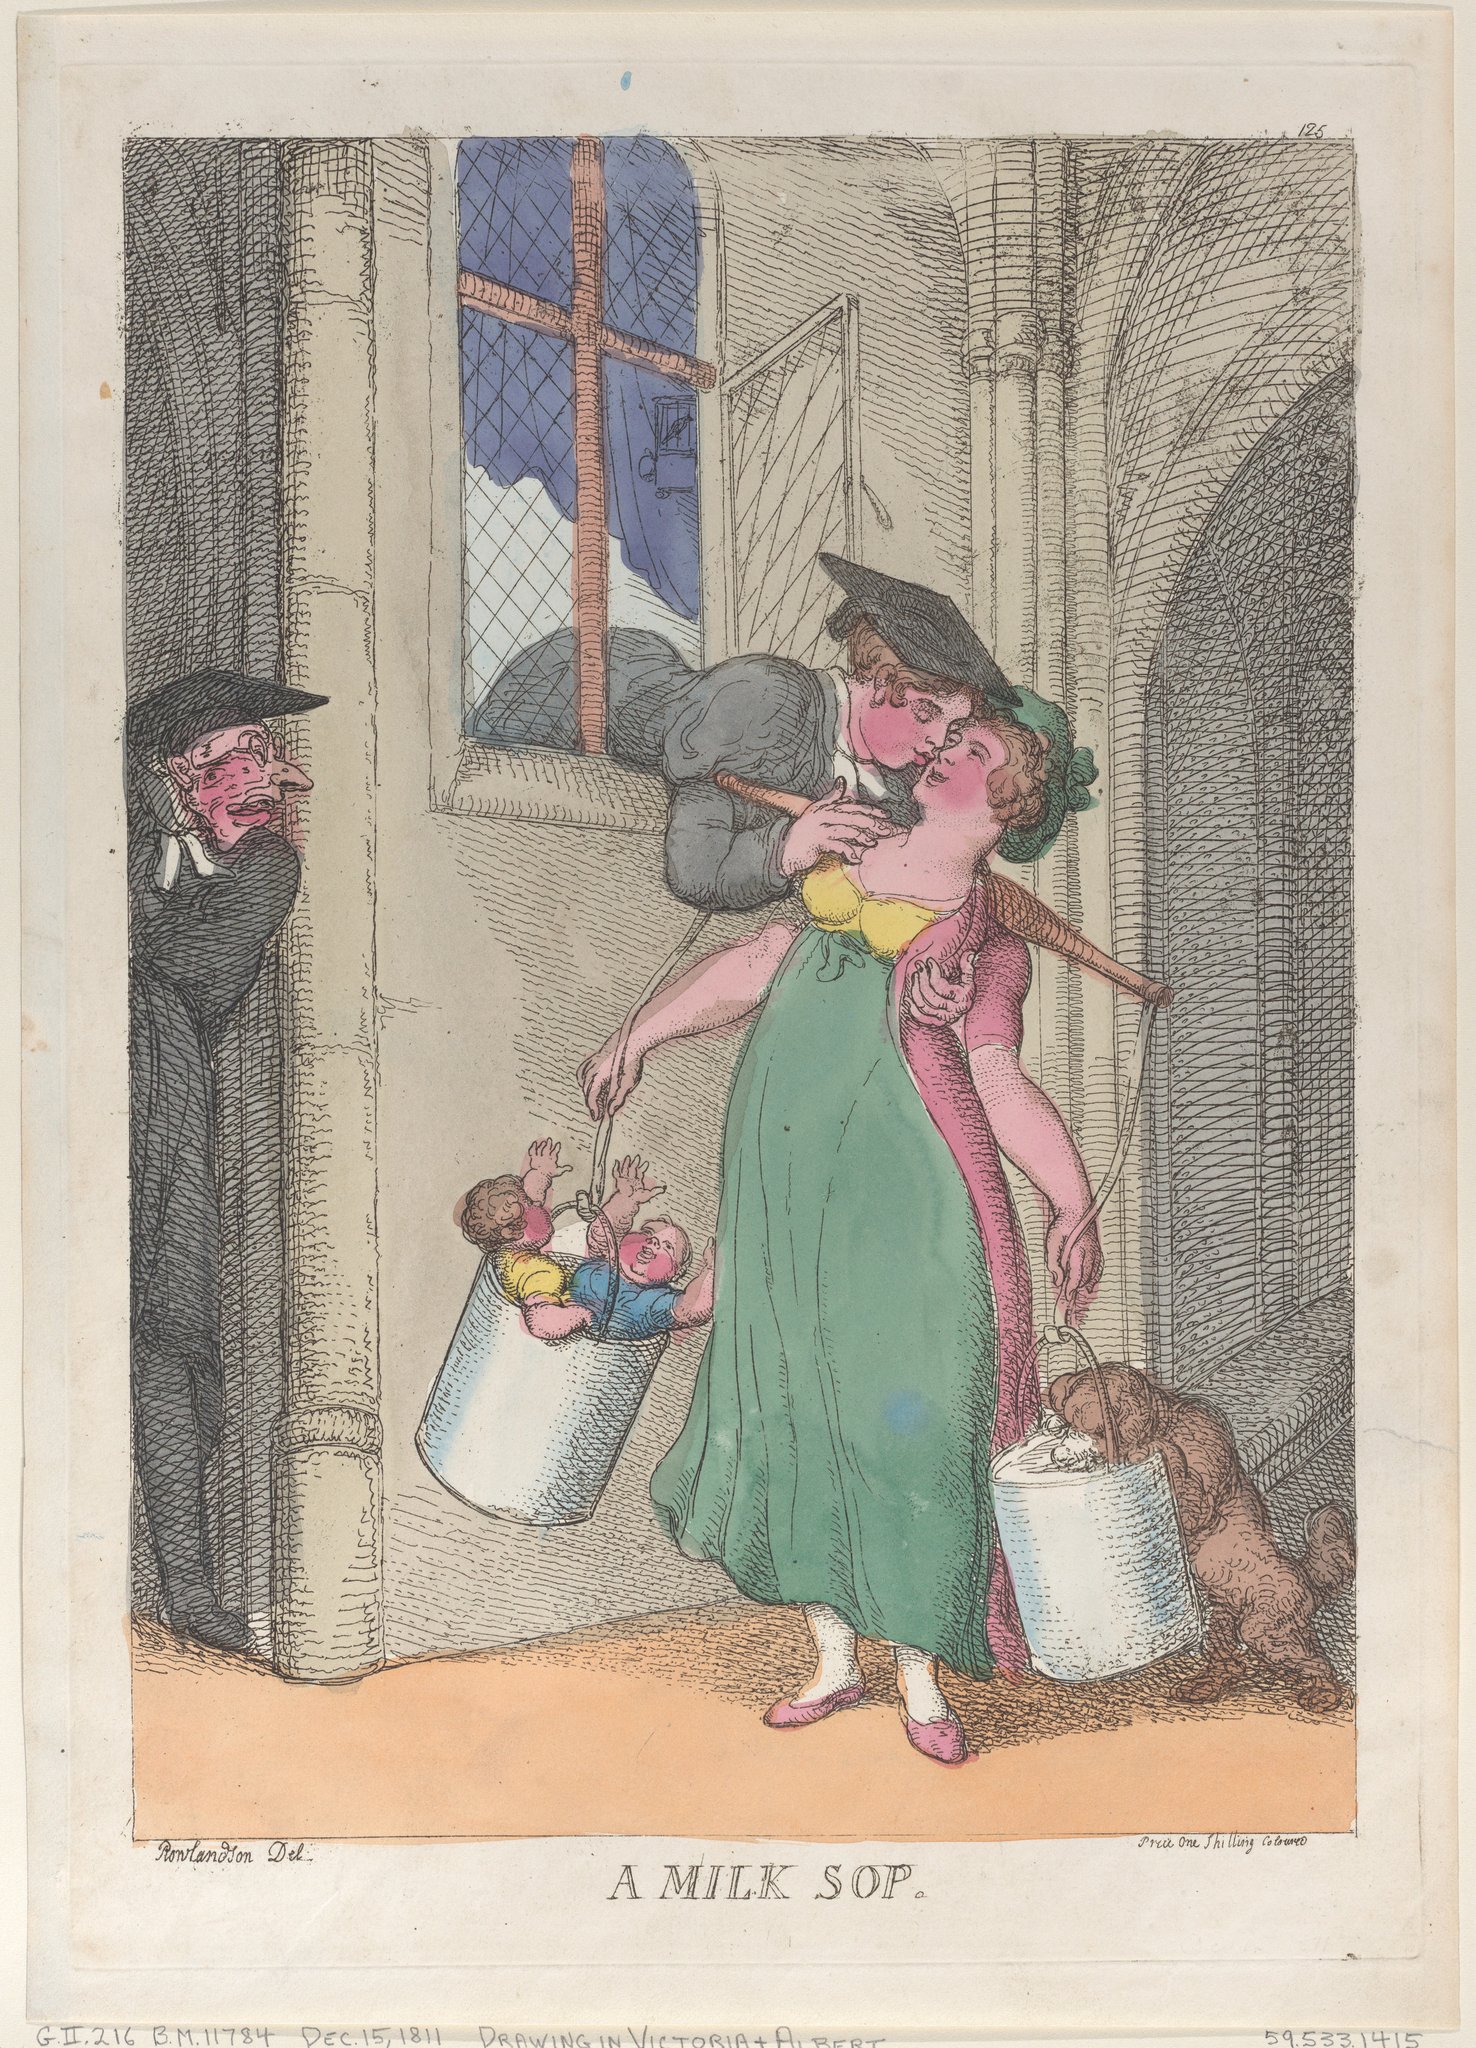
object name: print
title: A Milk Sop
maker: thomas rowlandson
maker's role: artist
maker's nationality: british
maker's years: 1757-1827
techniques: etching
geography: london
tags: satire,infants,men,women,dogs